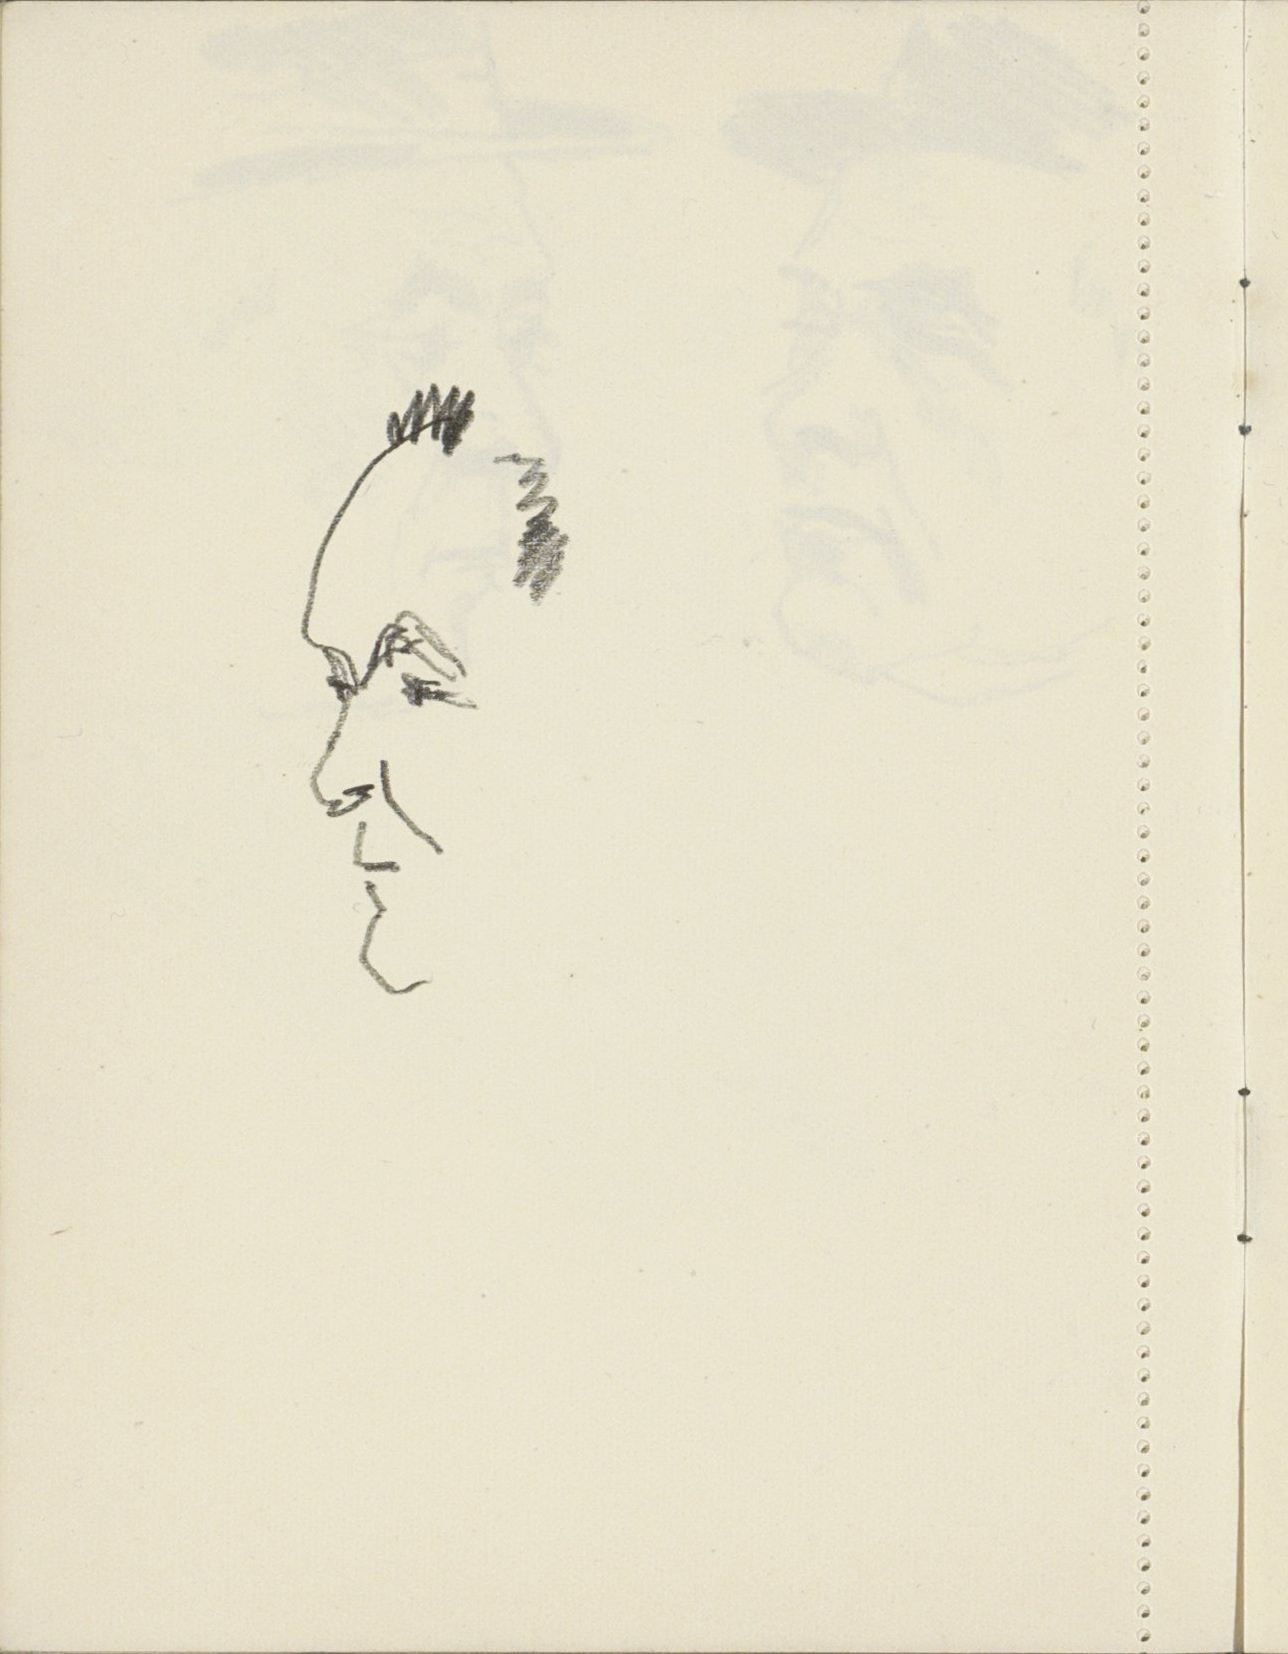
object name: sketchbook leaf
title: Kop van een man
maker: cornelis vreedenburgh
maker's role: draughtsman, print maker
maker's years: 1880-1946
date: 1890-1946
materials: paper, pencil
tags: head (human) (+ left side visible; left - (l. hand, l. foot, etc.))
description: Blad 17 verso uit een schetsboek met 71 bladen.